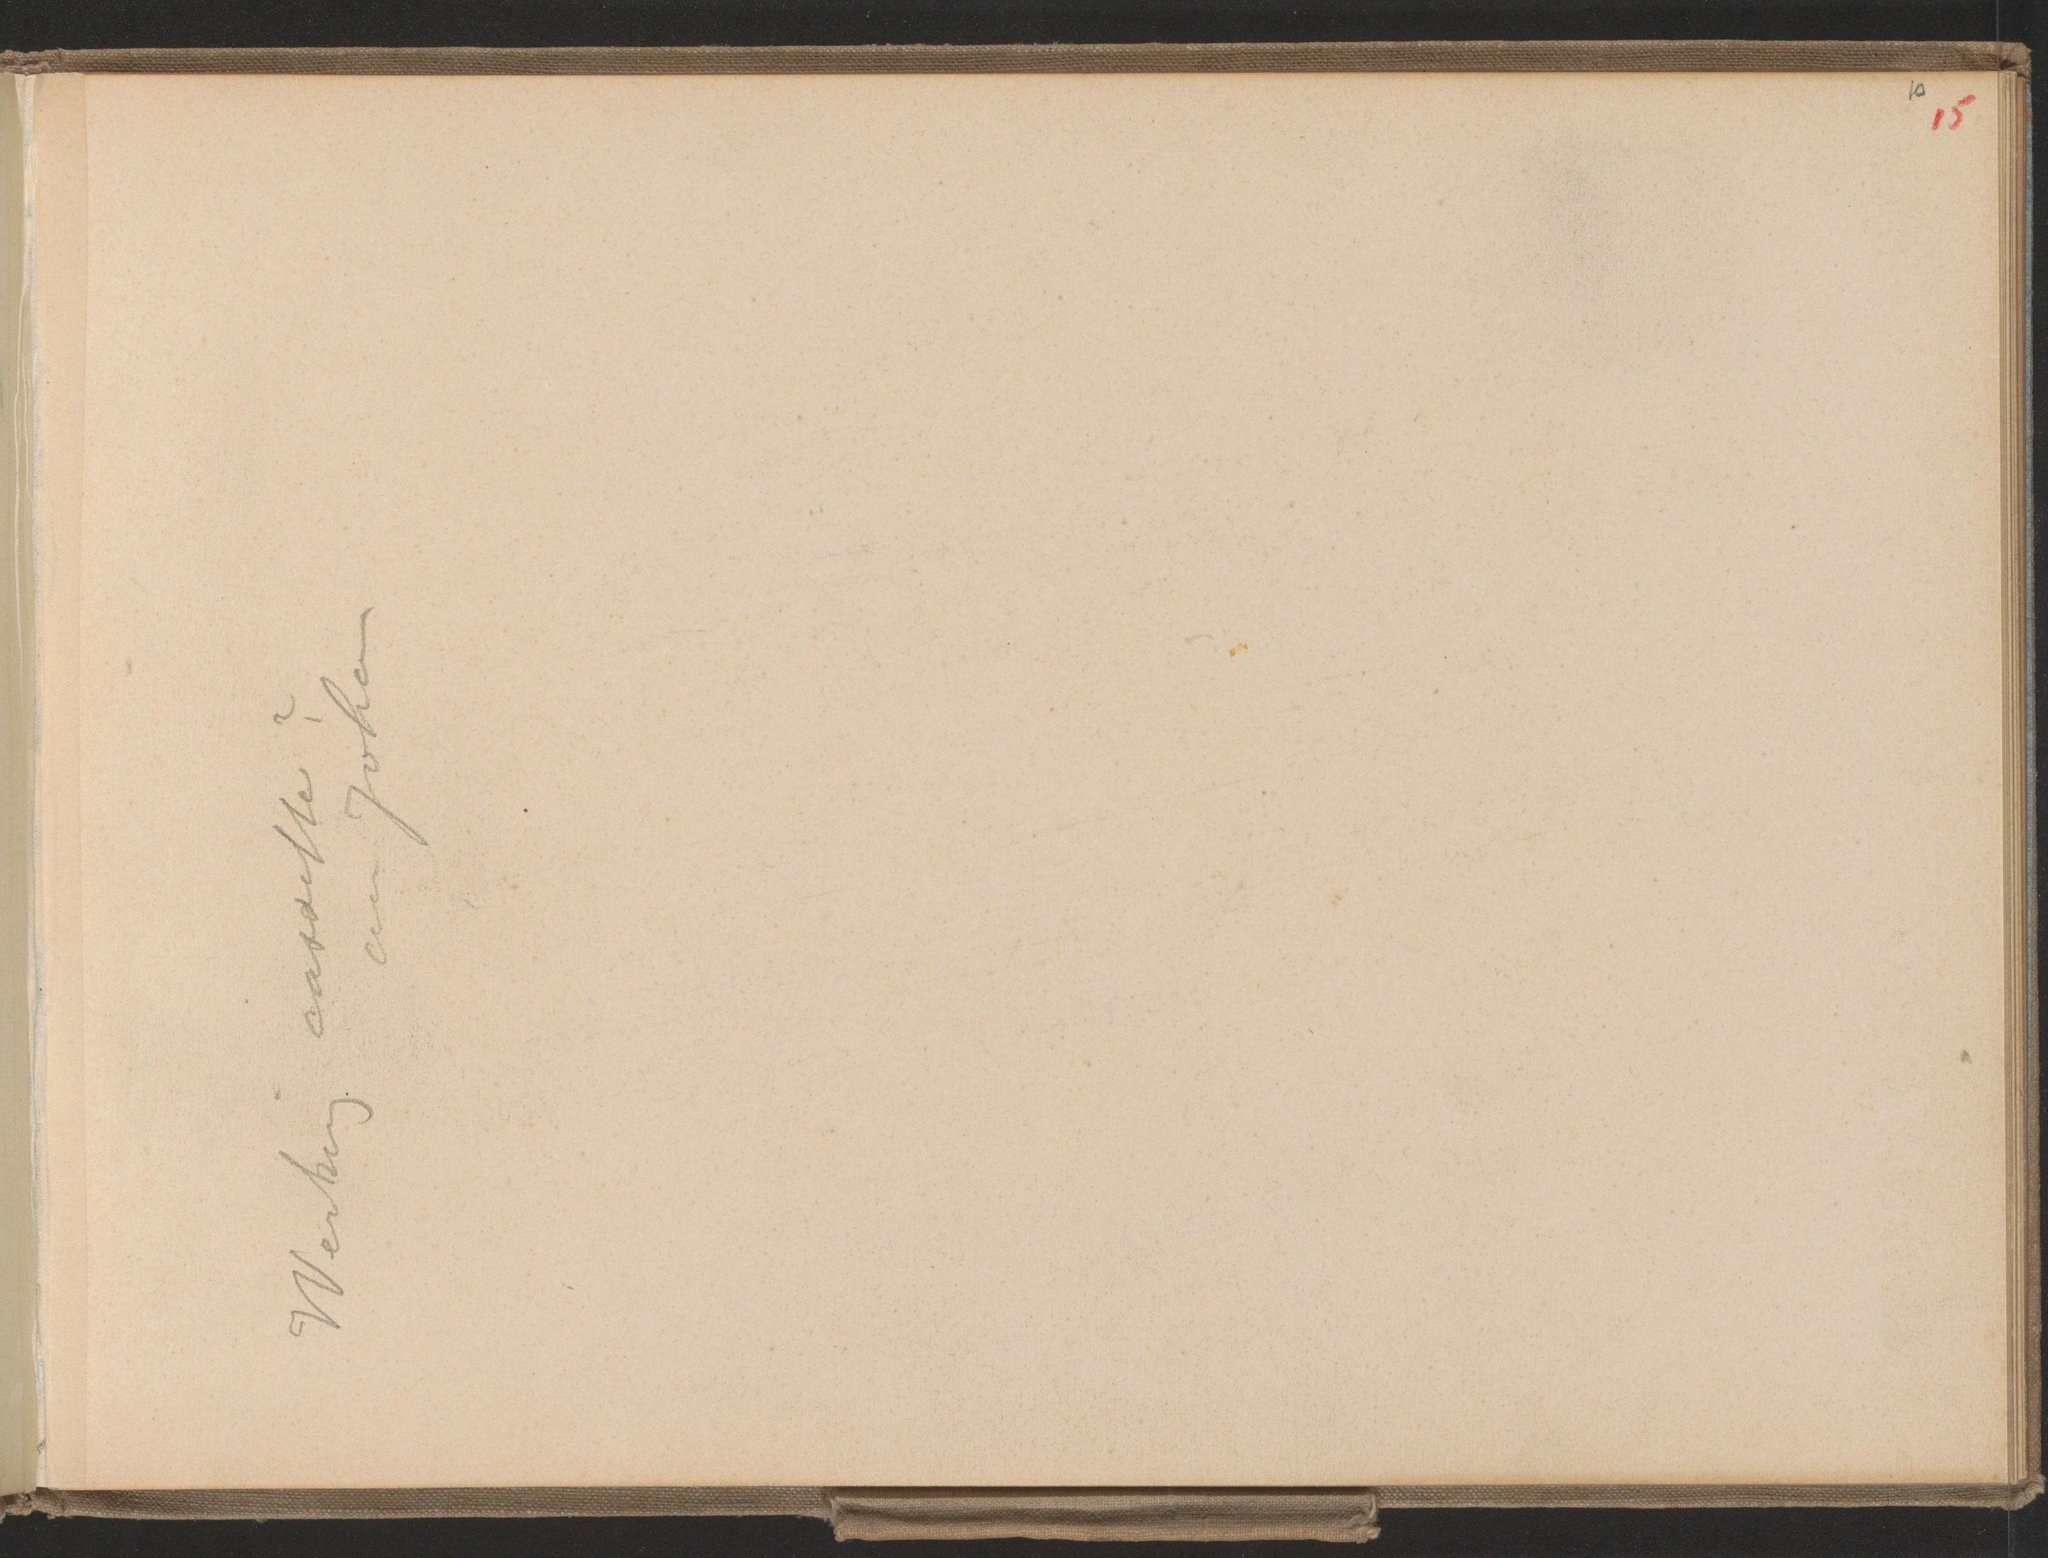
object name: sketchbook leaf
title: Notitie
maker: jozef israëls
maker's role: draughtsman, painter, print maker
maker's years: 1824-1911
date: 1834-1911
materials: paper, pencil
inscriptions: annotation: ‘Werbe[...] cassette?/ aan Johan’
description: Blad 10 recto uit een schetsboek met 27 bladen.